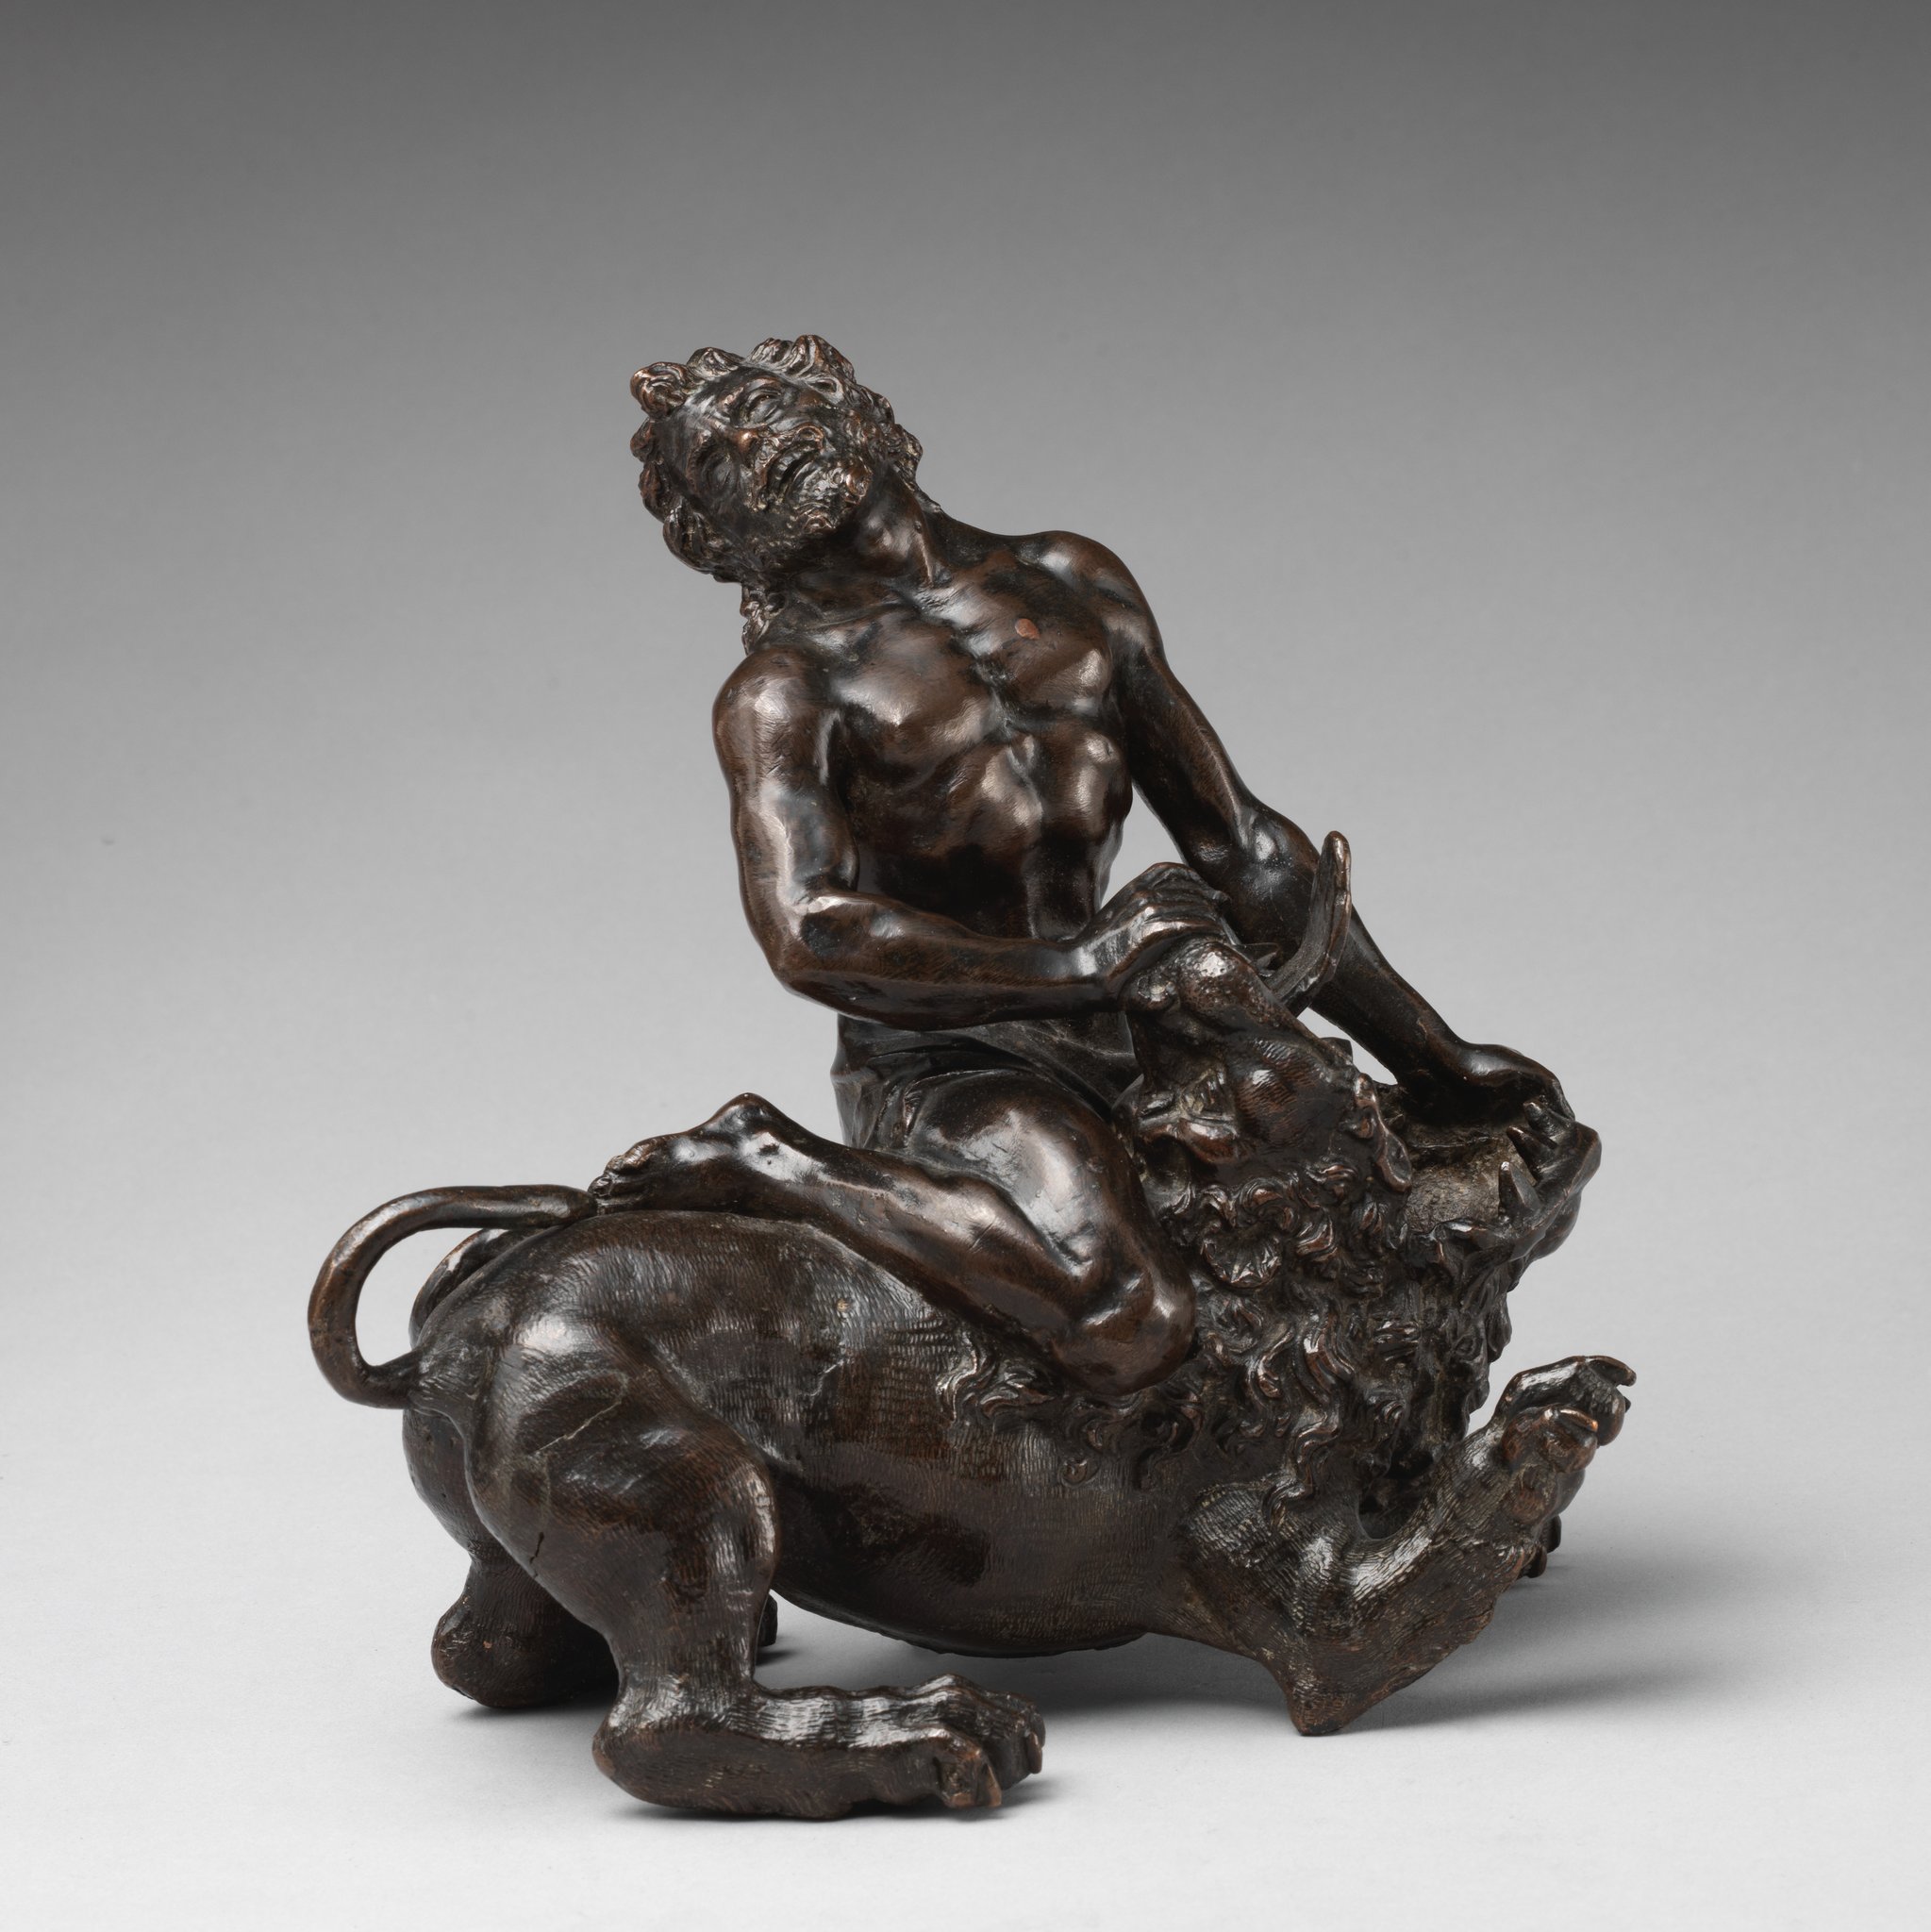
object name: statuette group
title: Samson and the Lion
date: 1601-1700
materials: bronze, lacquer, patina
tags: lions,samson